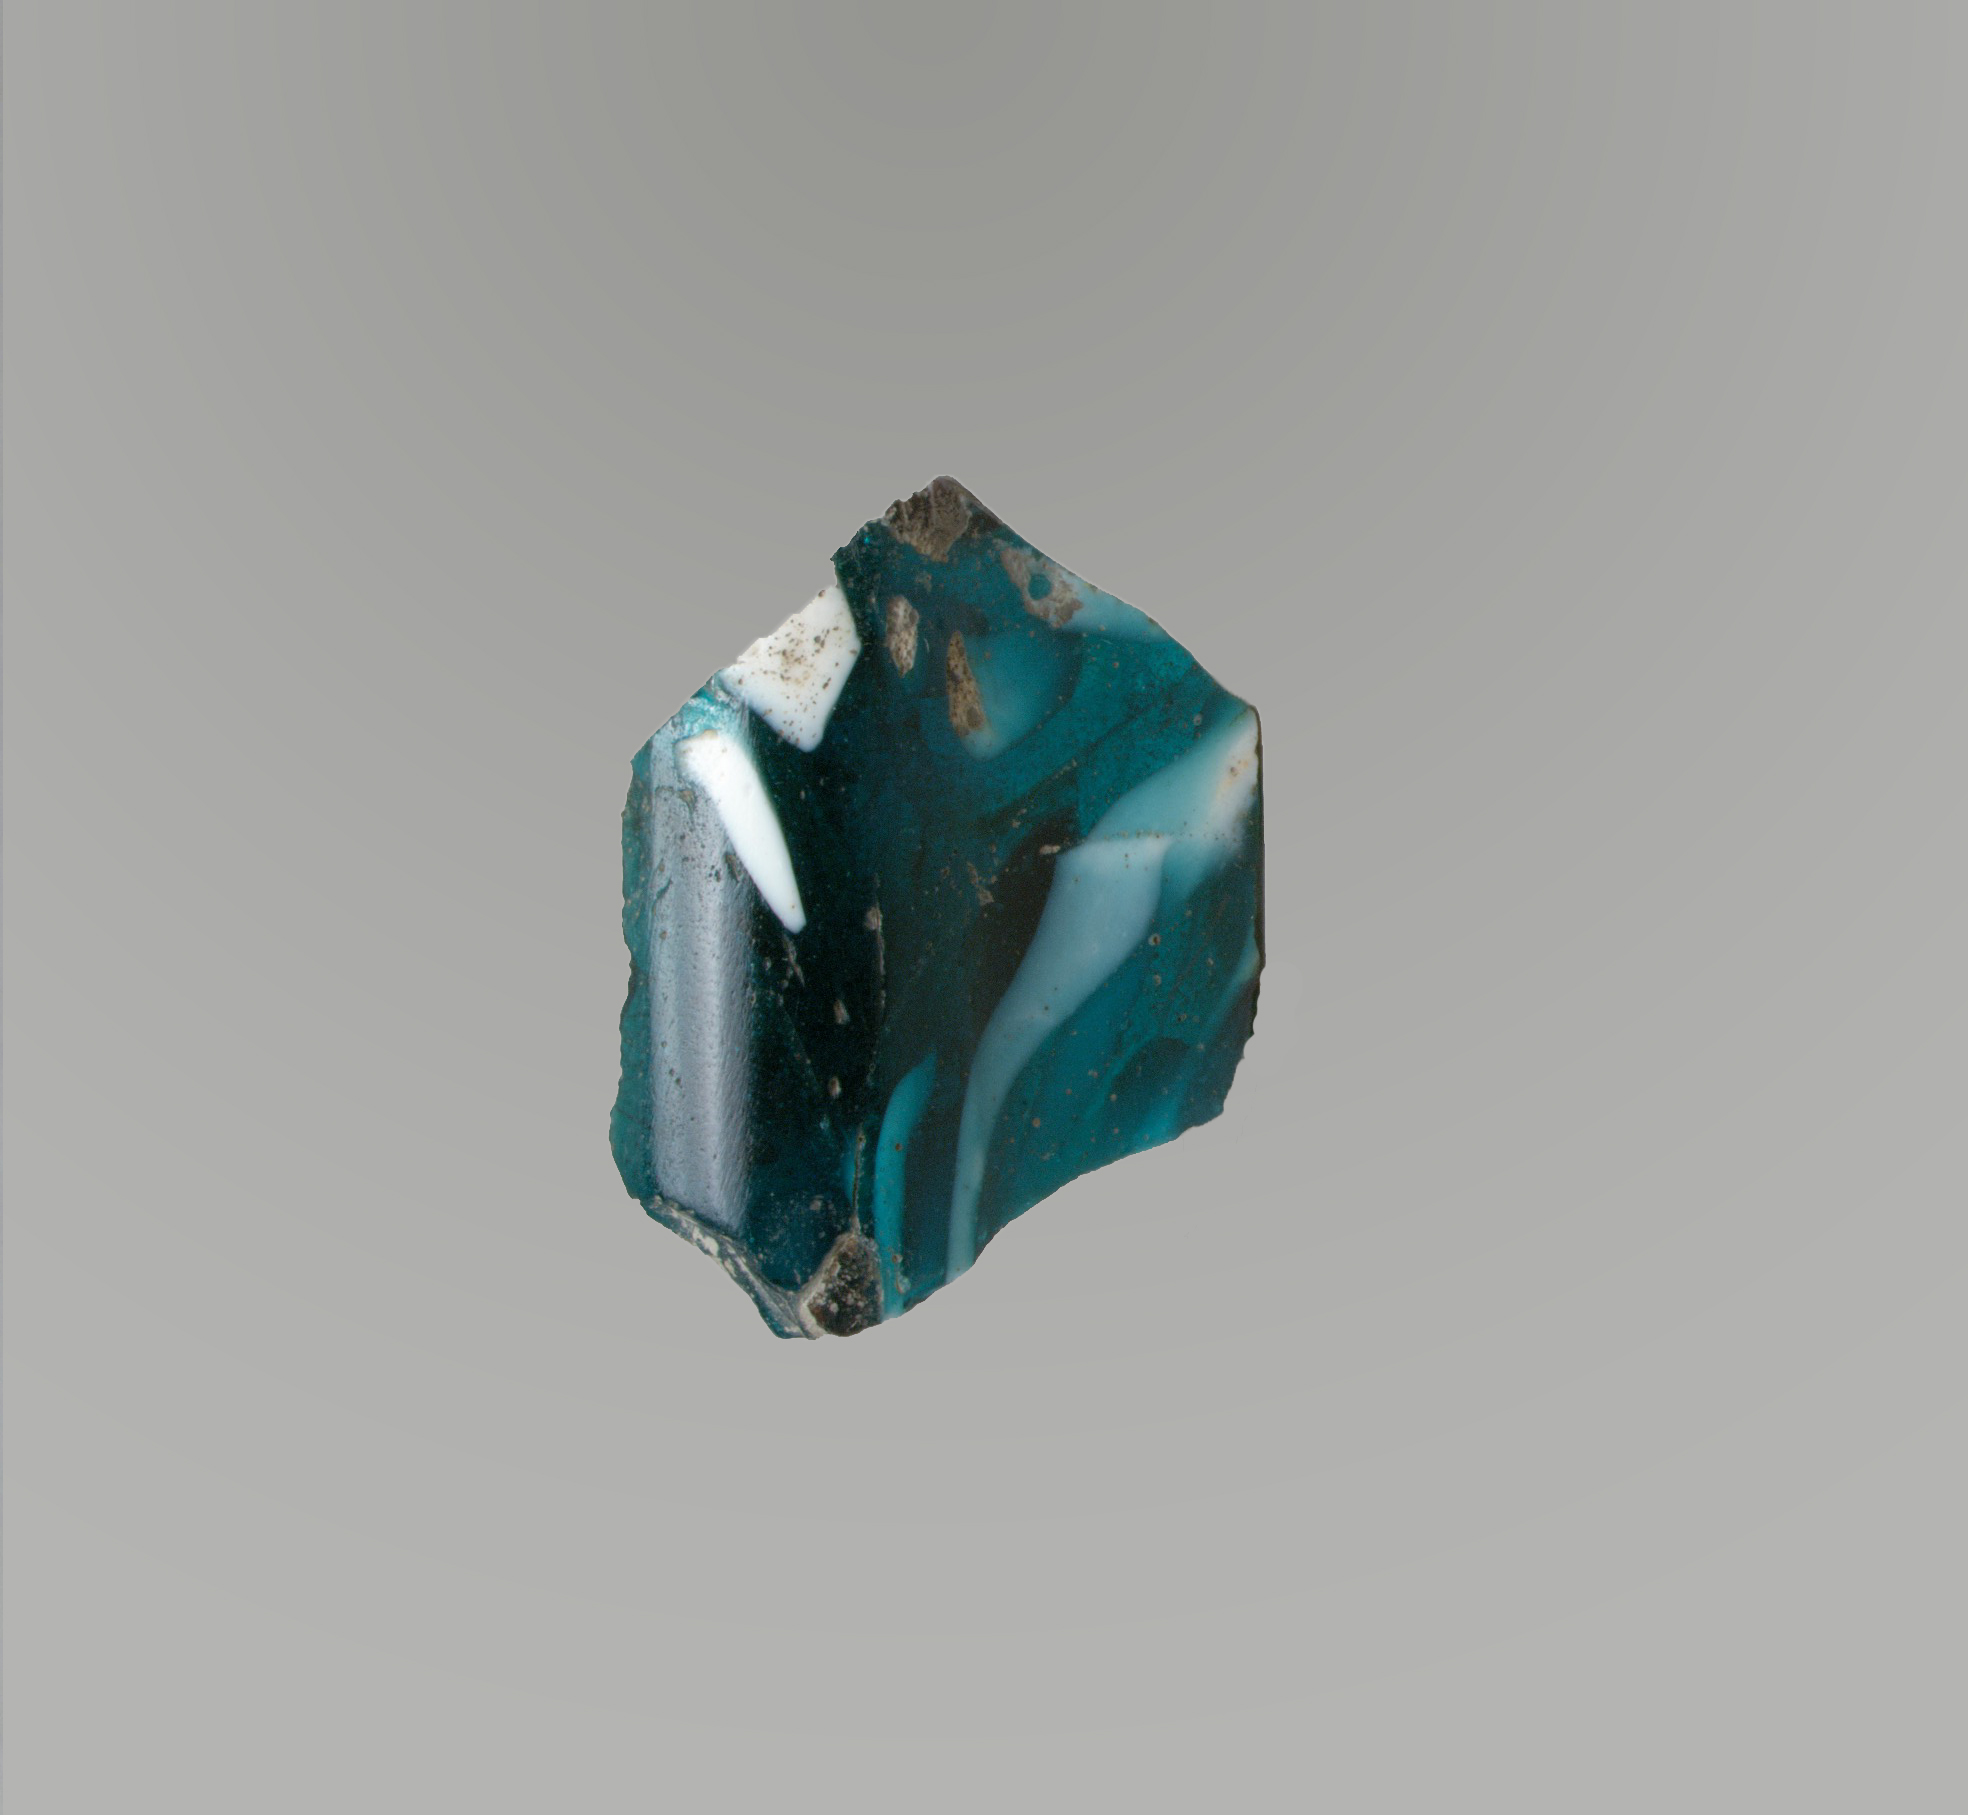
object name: fragment, mosaic bowl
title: Glass mosaic ribbed bowl fragment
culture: roman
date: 34 BCE-33 CE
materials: glass